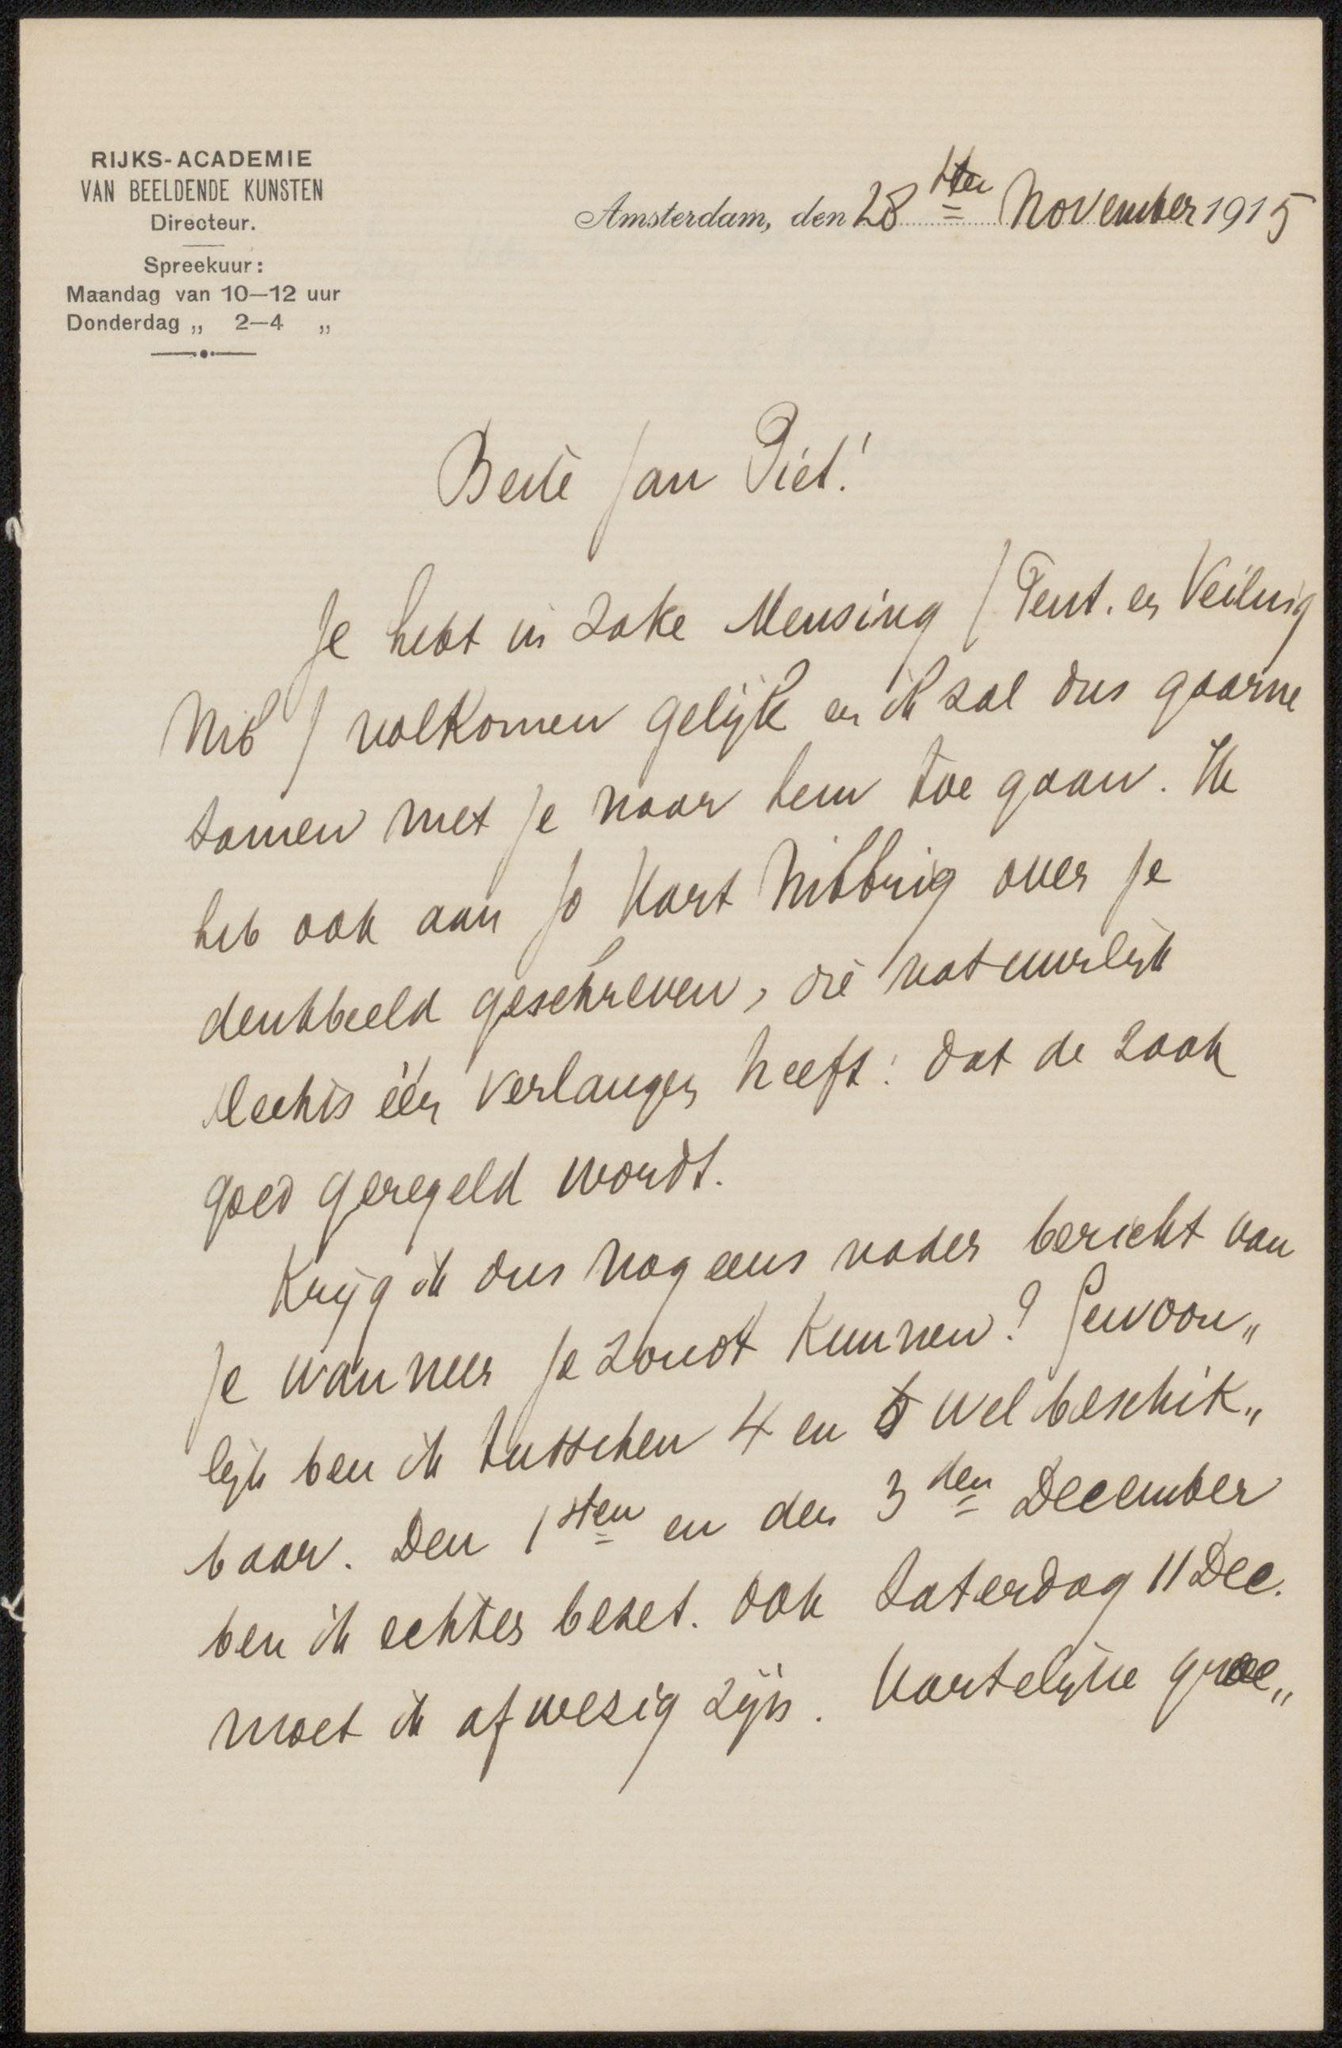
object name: letter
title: Brief aan Jan Veth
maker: antoon derkinderen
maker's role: draughtsman, painter, print maker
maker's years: 1859-1925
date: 1915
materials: ink, paper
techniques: pen, printing, writing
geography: amsterdam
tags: dordrecht, painter, print maker, draughtsman, designer, jan veth, ferdinand hart nibbrig, antonius wilhelmus mari mensing, art trade, art shop, exhibition ~ art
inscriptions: collector's mark: ‘RPK’